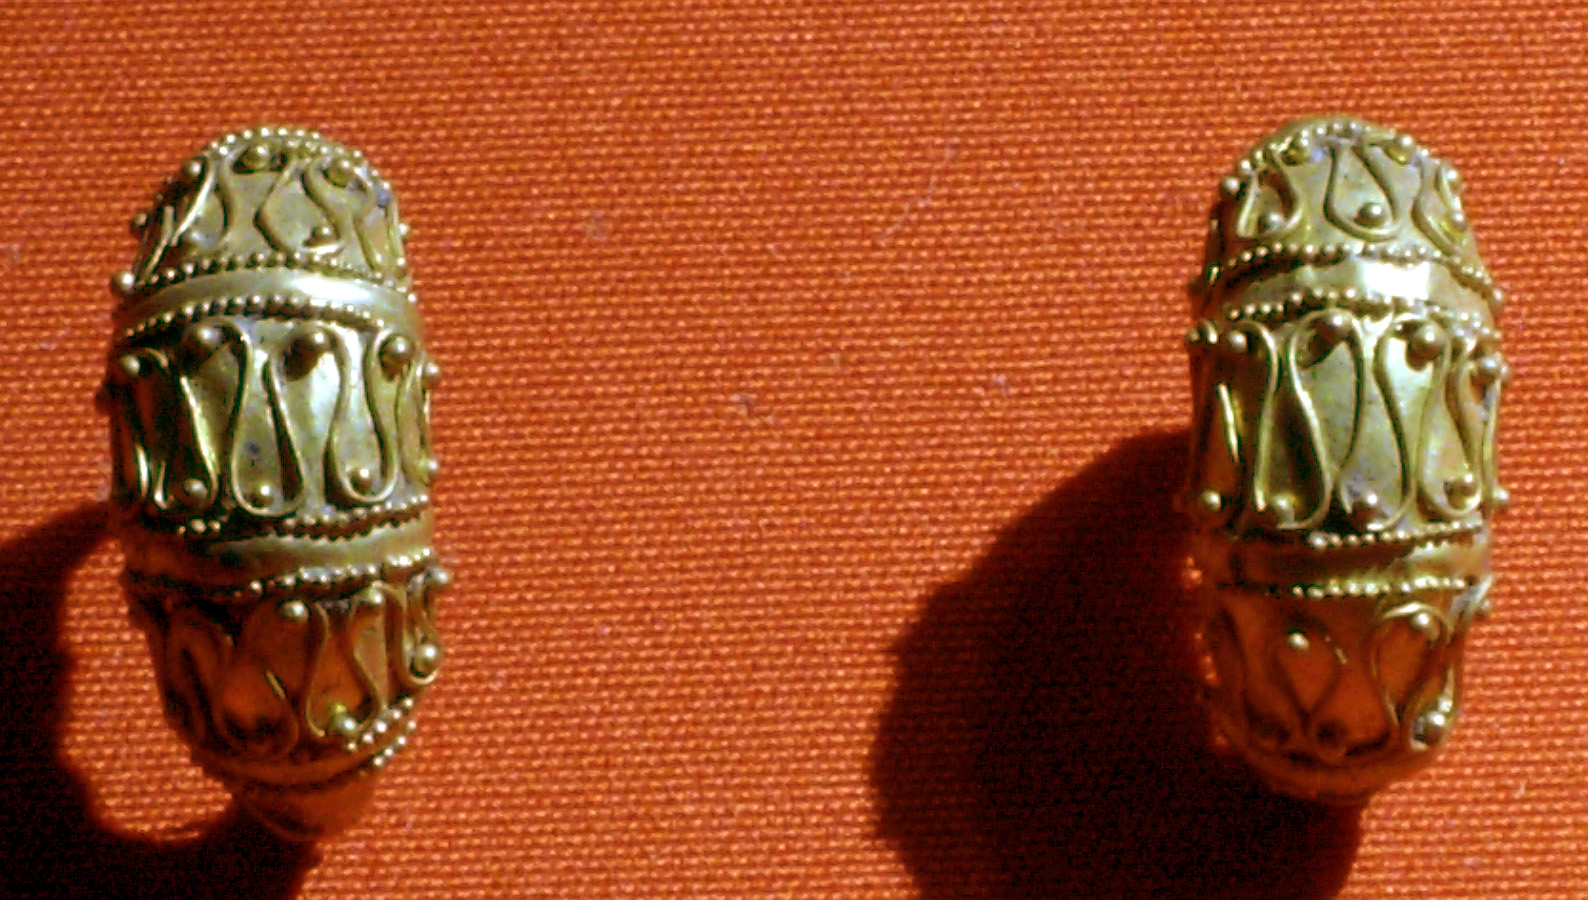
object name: earring, boat shaped, filagree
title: Pair of boat-shaped earrings with filigree and granule decoration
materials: gold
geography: egypt